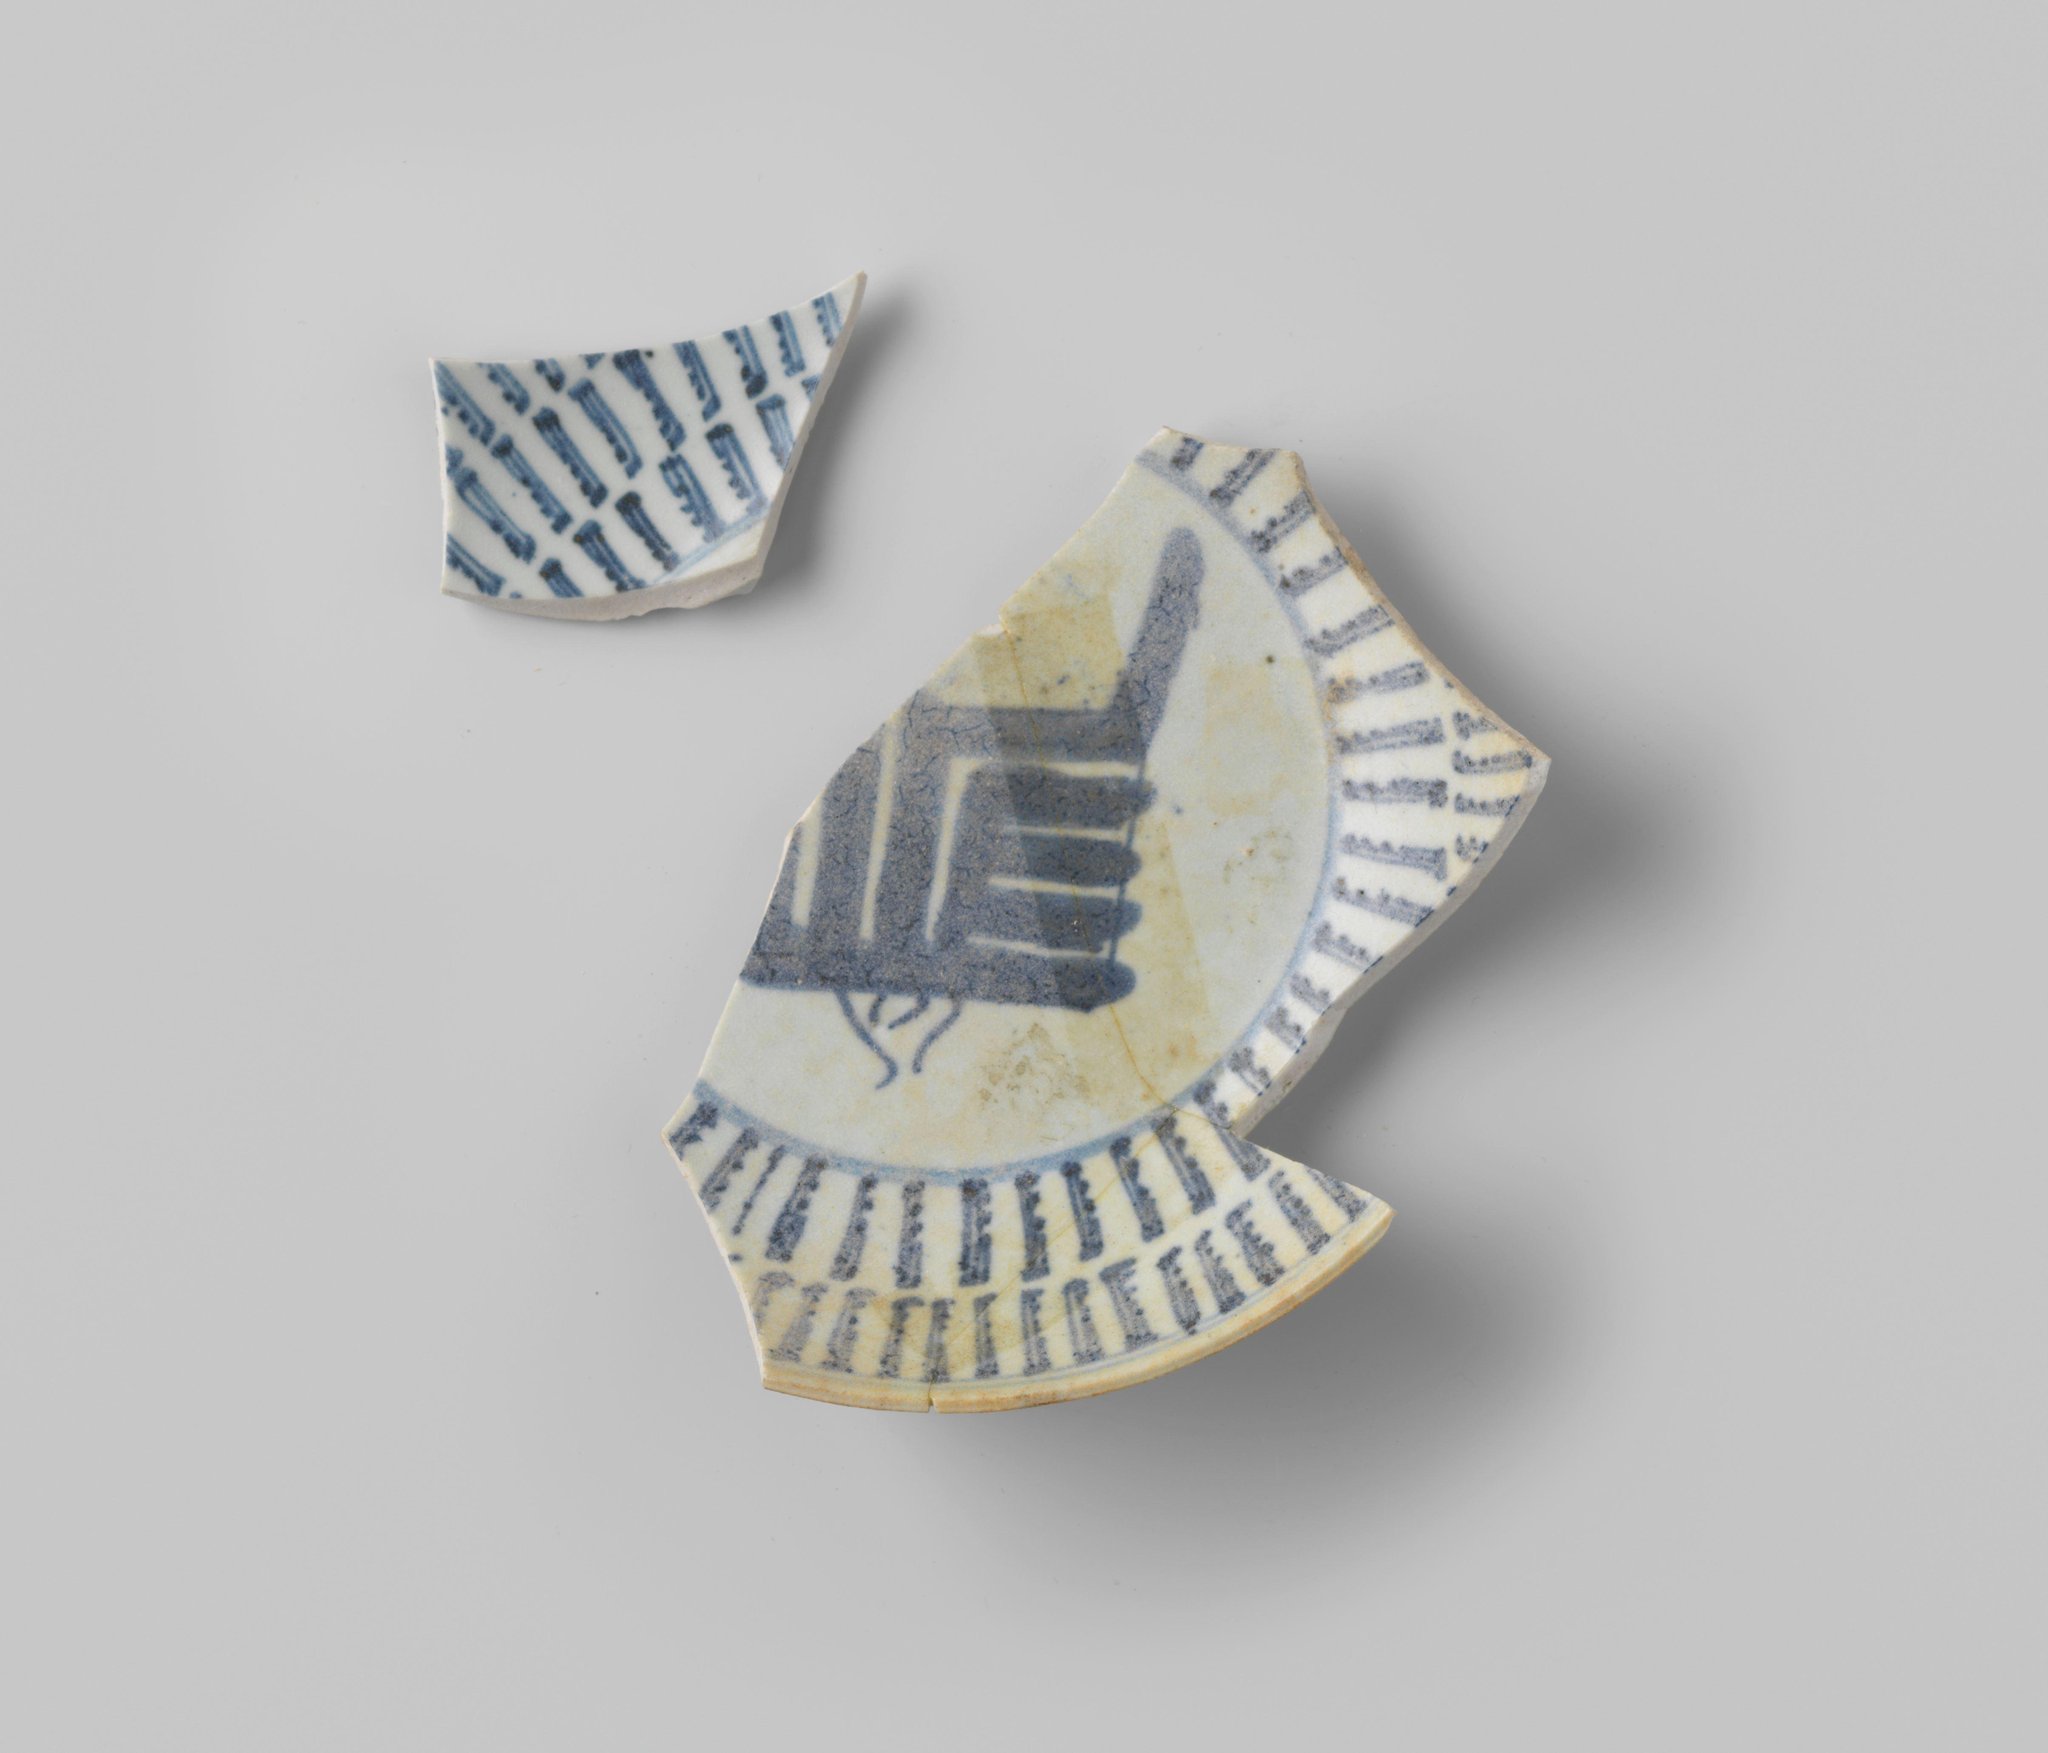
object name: bowl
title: Scherven van kommen uit V.O.C.-schip de 'Witte Leeuw'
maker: Anonymous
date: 1613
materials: porcelain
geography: jingdezhen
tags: verenigde oostindische compagnie, sint-helena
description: A bowl with a 'comb' motive. In the centre a single comb motive is drawn, surrounded by a double band. On the outside four layers with comb-design.